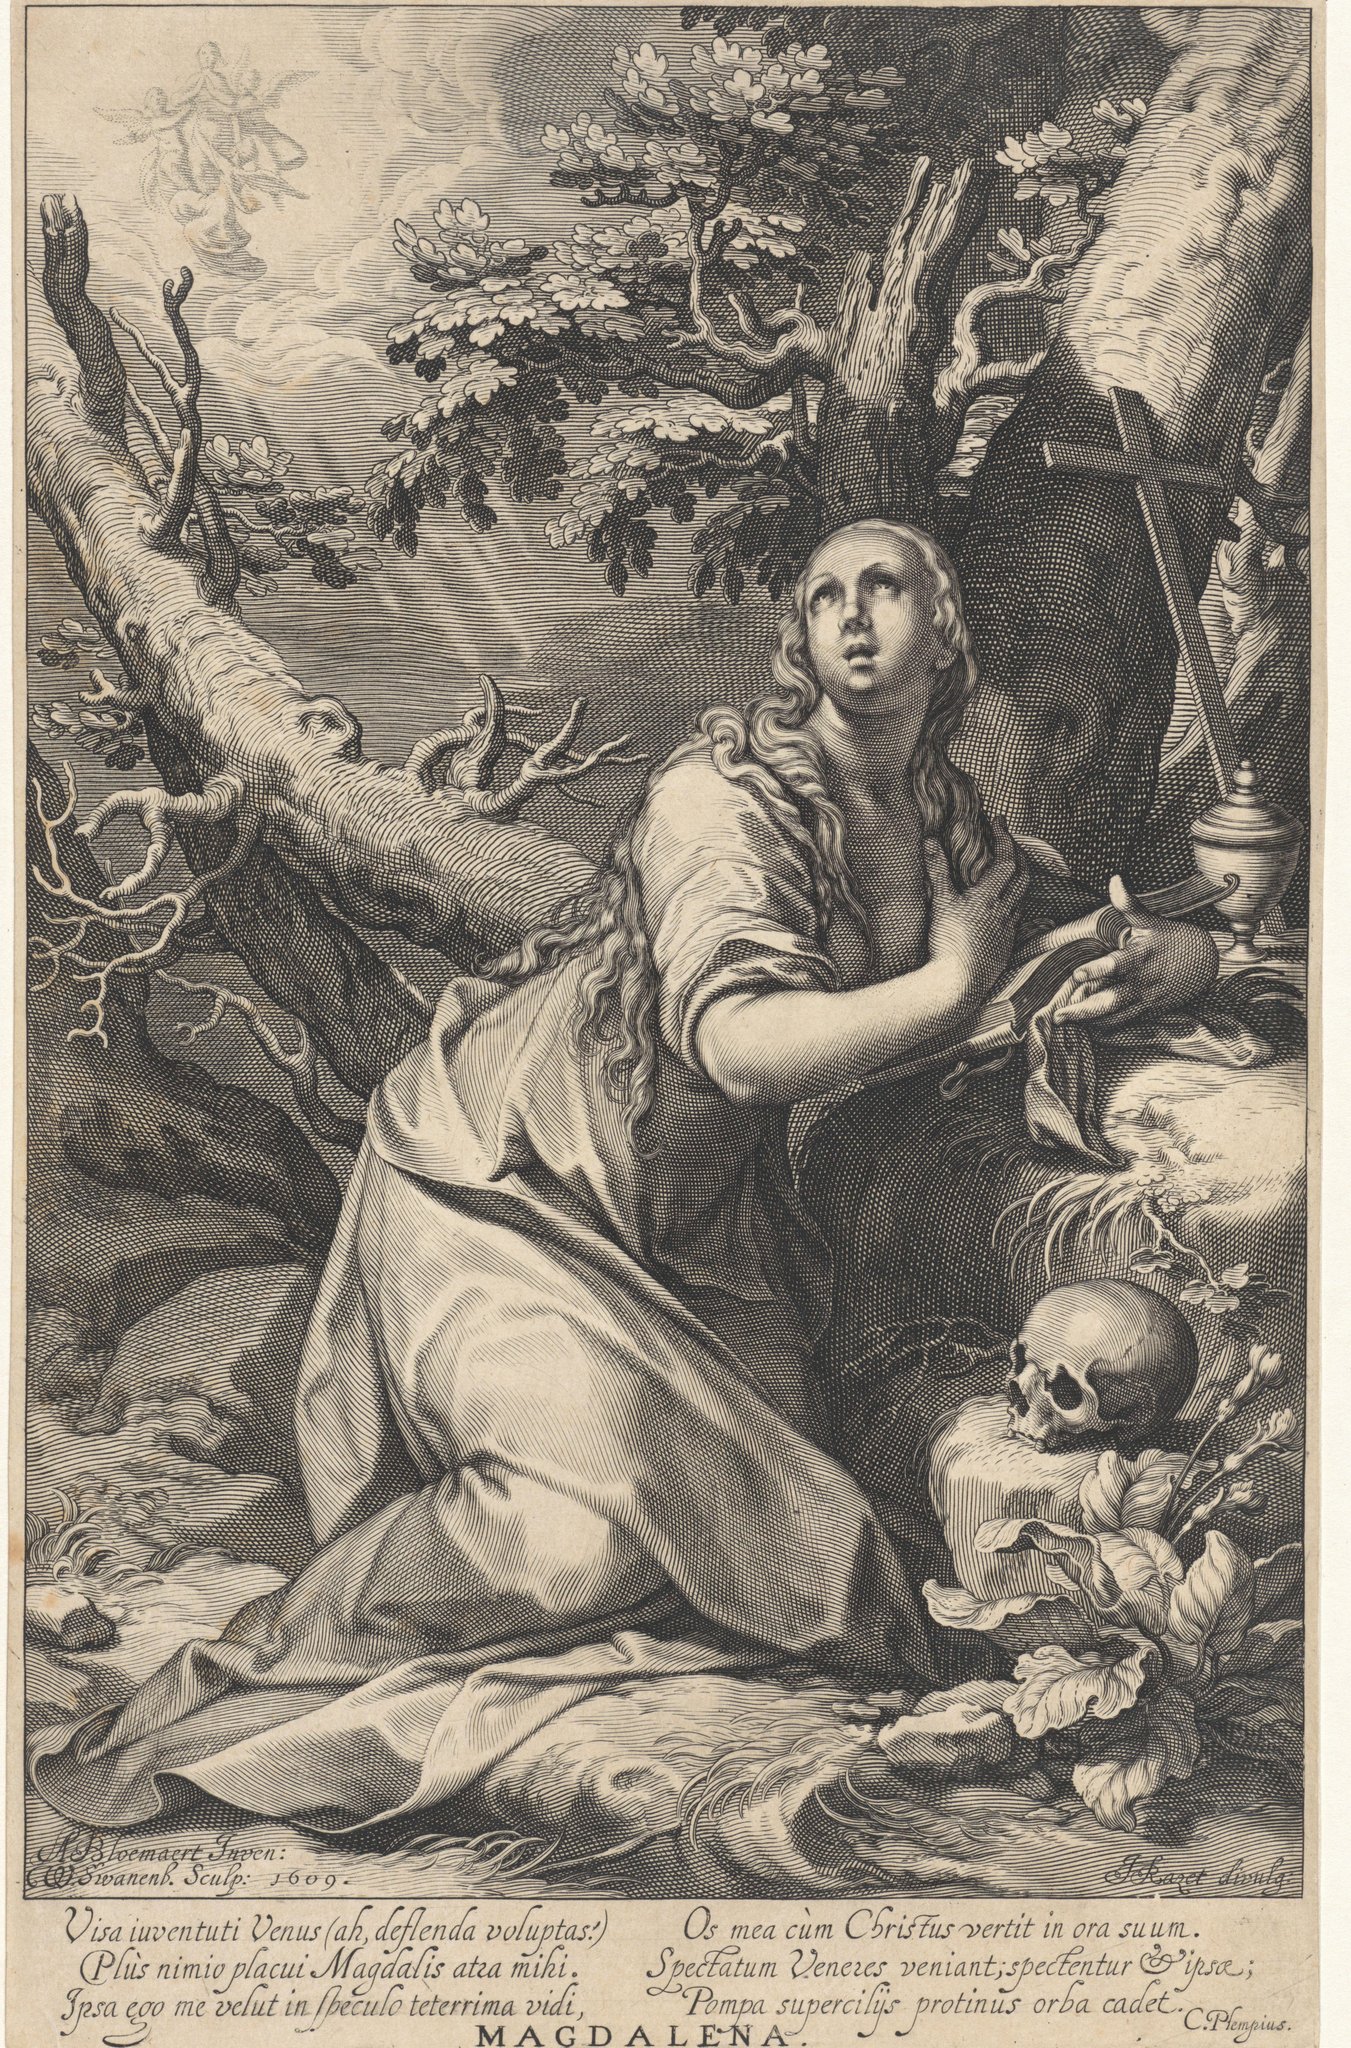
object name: print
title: Boetvaardige H. Maria Magdalena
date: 1609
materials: paper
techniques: engraving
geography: utrecht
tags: landscapes, the assumption of st. mary magdalene: she is lifted up to heaven by angels; sometimes a hermit looks up at her, the penitent harlot mary magdalene; possible attributes: book (or scroll), crown, crown of thorns, crucifix, jar of ointment, mirror, musical instrument, palm-branch, rosary, scourge - portrait of female saint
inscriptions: collector's mark: Lugt 240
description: Maria Magdalena knielt bij een boom. Ze houdt een geopend boek vast. Voor haar staat een zalfpot en een crucifix. Bij haar knie ligt een doodskop. In de verte is haar hemelvaart weergegeven. Onder de voorstelling bevindt zich een zesregelige, Latijnse tekst waarin gerefereerd wordt aan de gelijkenis tussen Maria Magdalena en Venus.